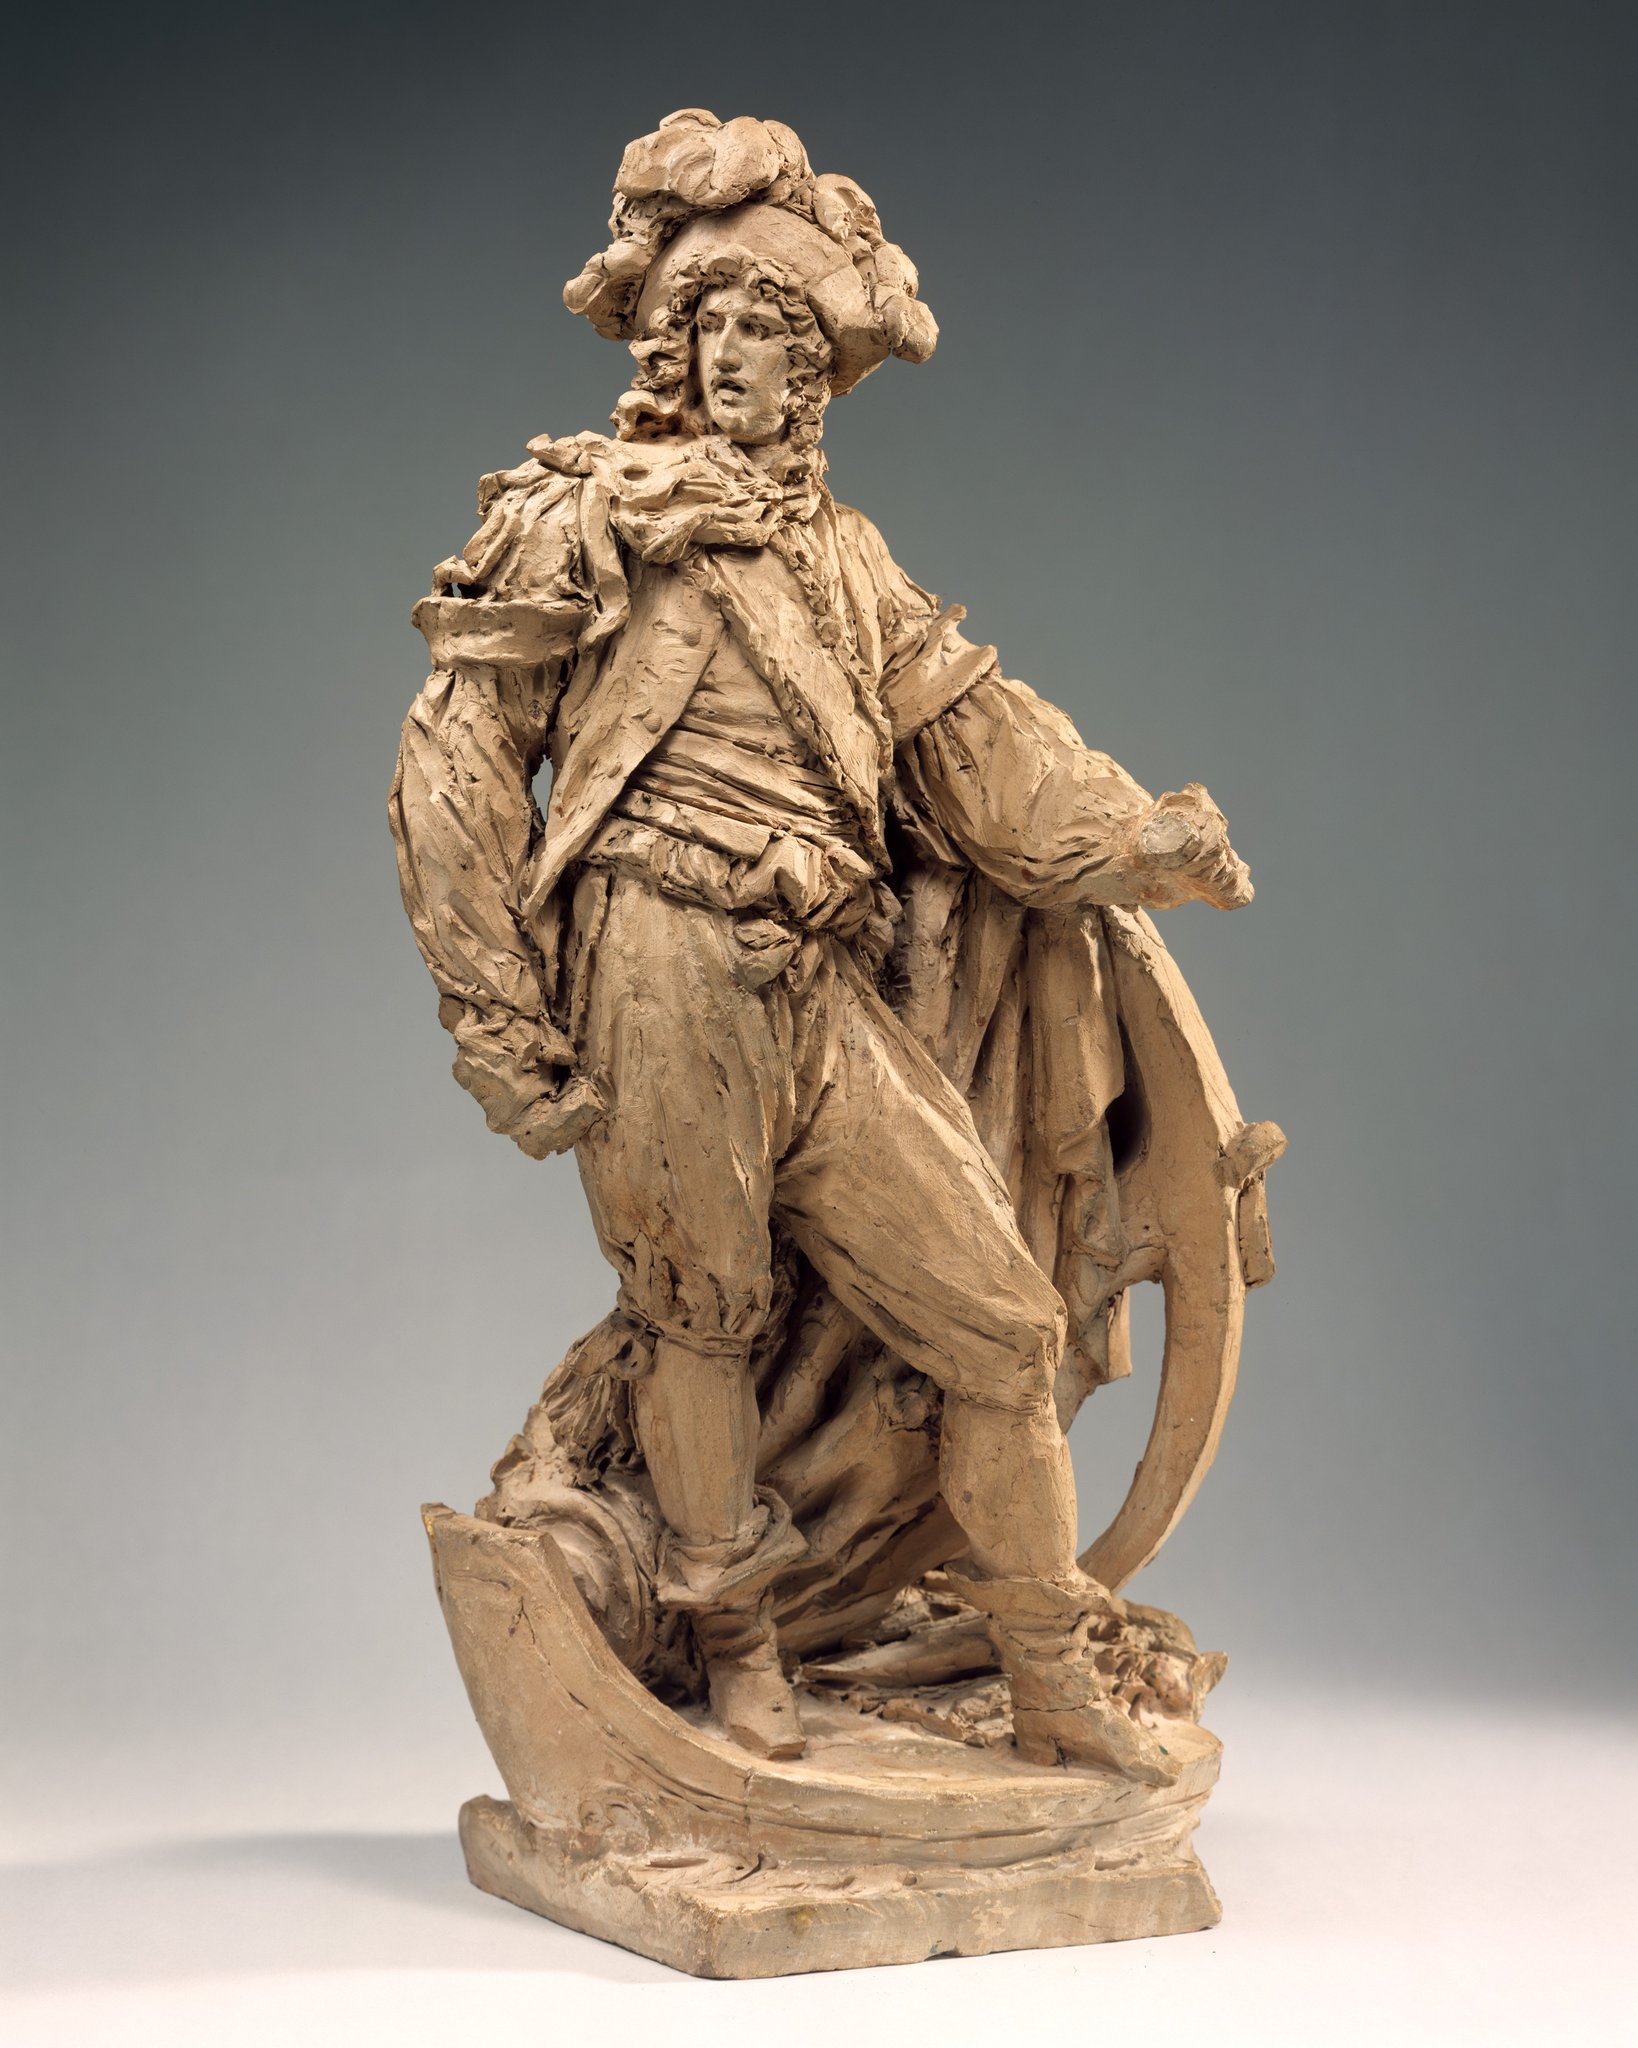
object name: model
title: Admiral de Tourville (1642–1701)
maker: joseph-charles marin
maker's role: artist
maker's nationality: french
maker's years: 1759-1834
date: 1816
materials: terracotta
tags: men,admirals